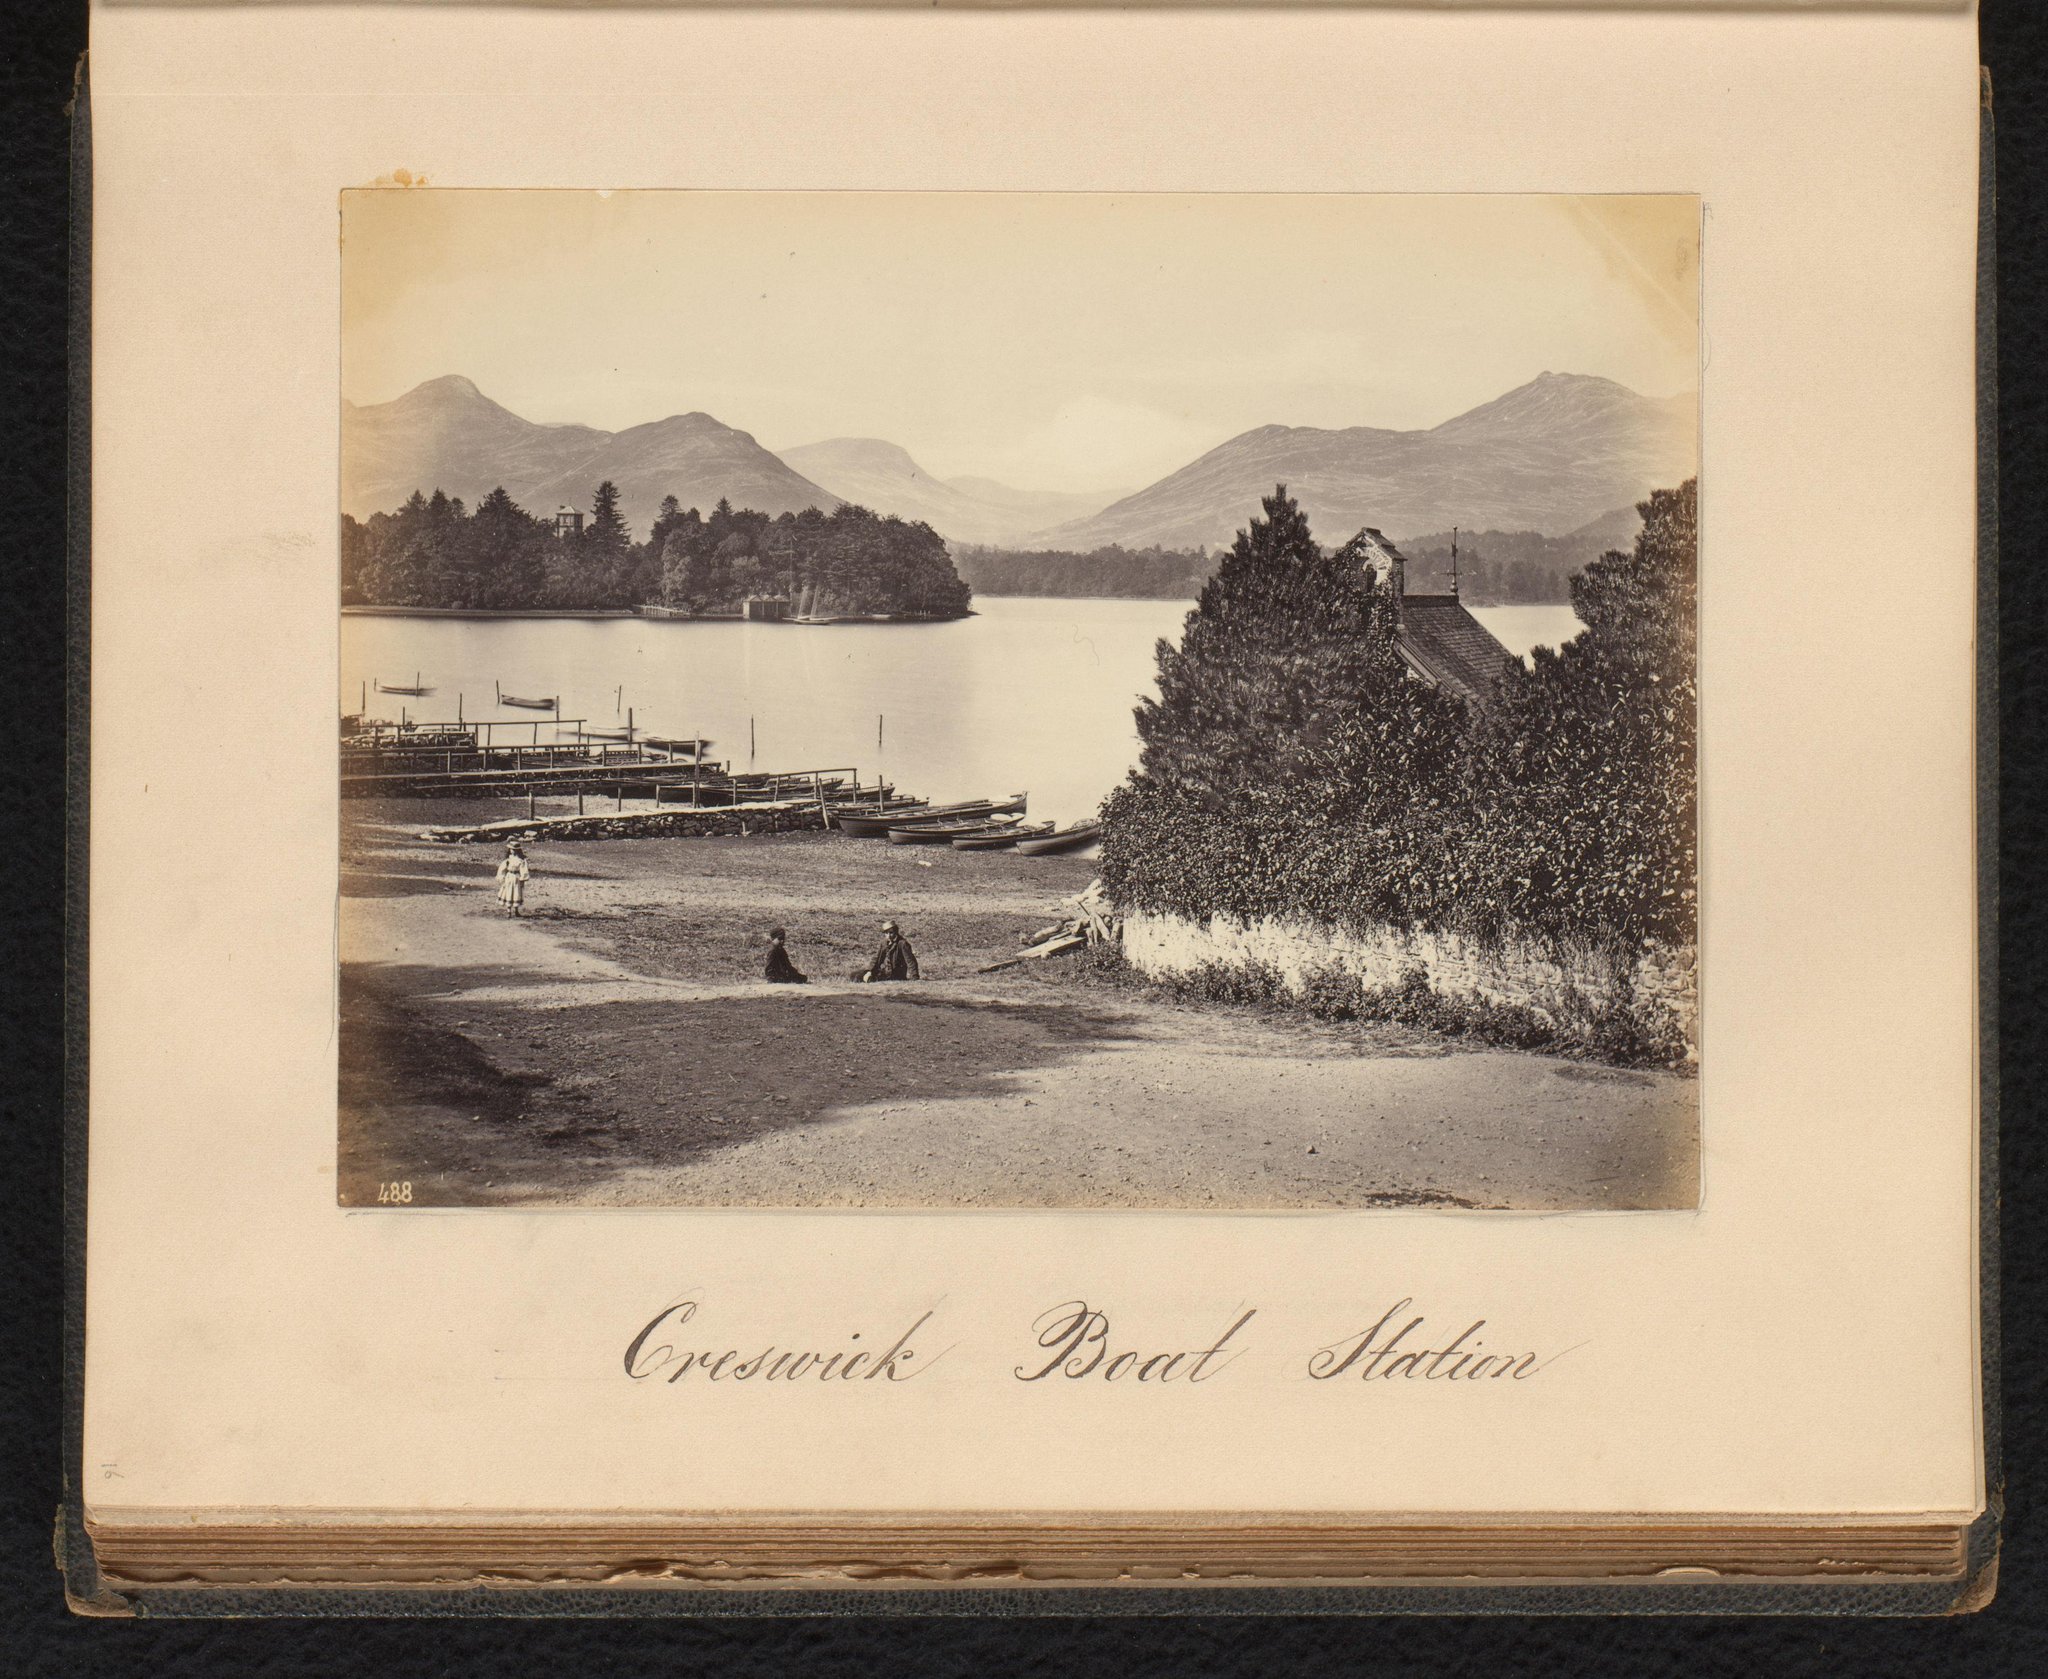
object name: photograph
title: Gezicht op een meer in het Lake District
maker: Anonymous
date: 1860-1870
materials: paper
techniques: albumen print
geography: lake district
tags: lake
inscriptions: number: ‘488’